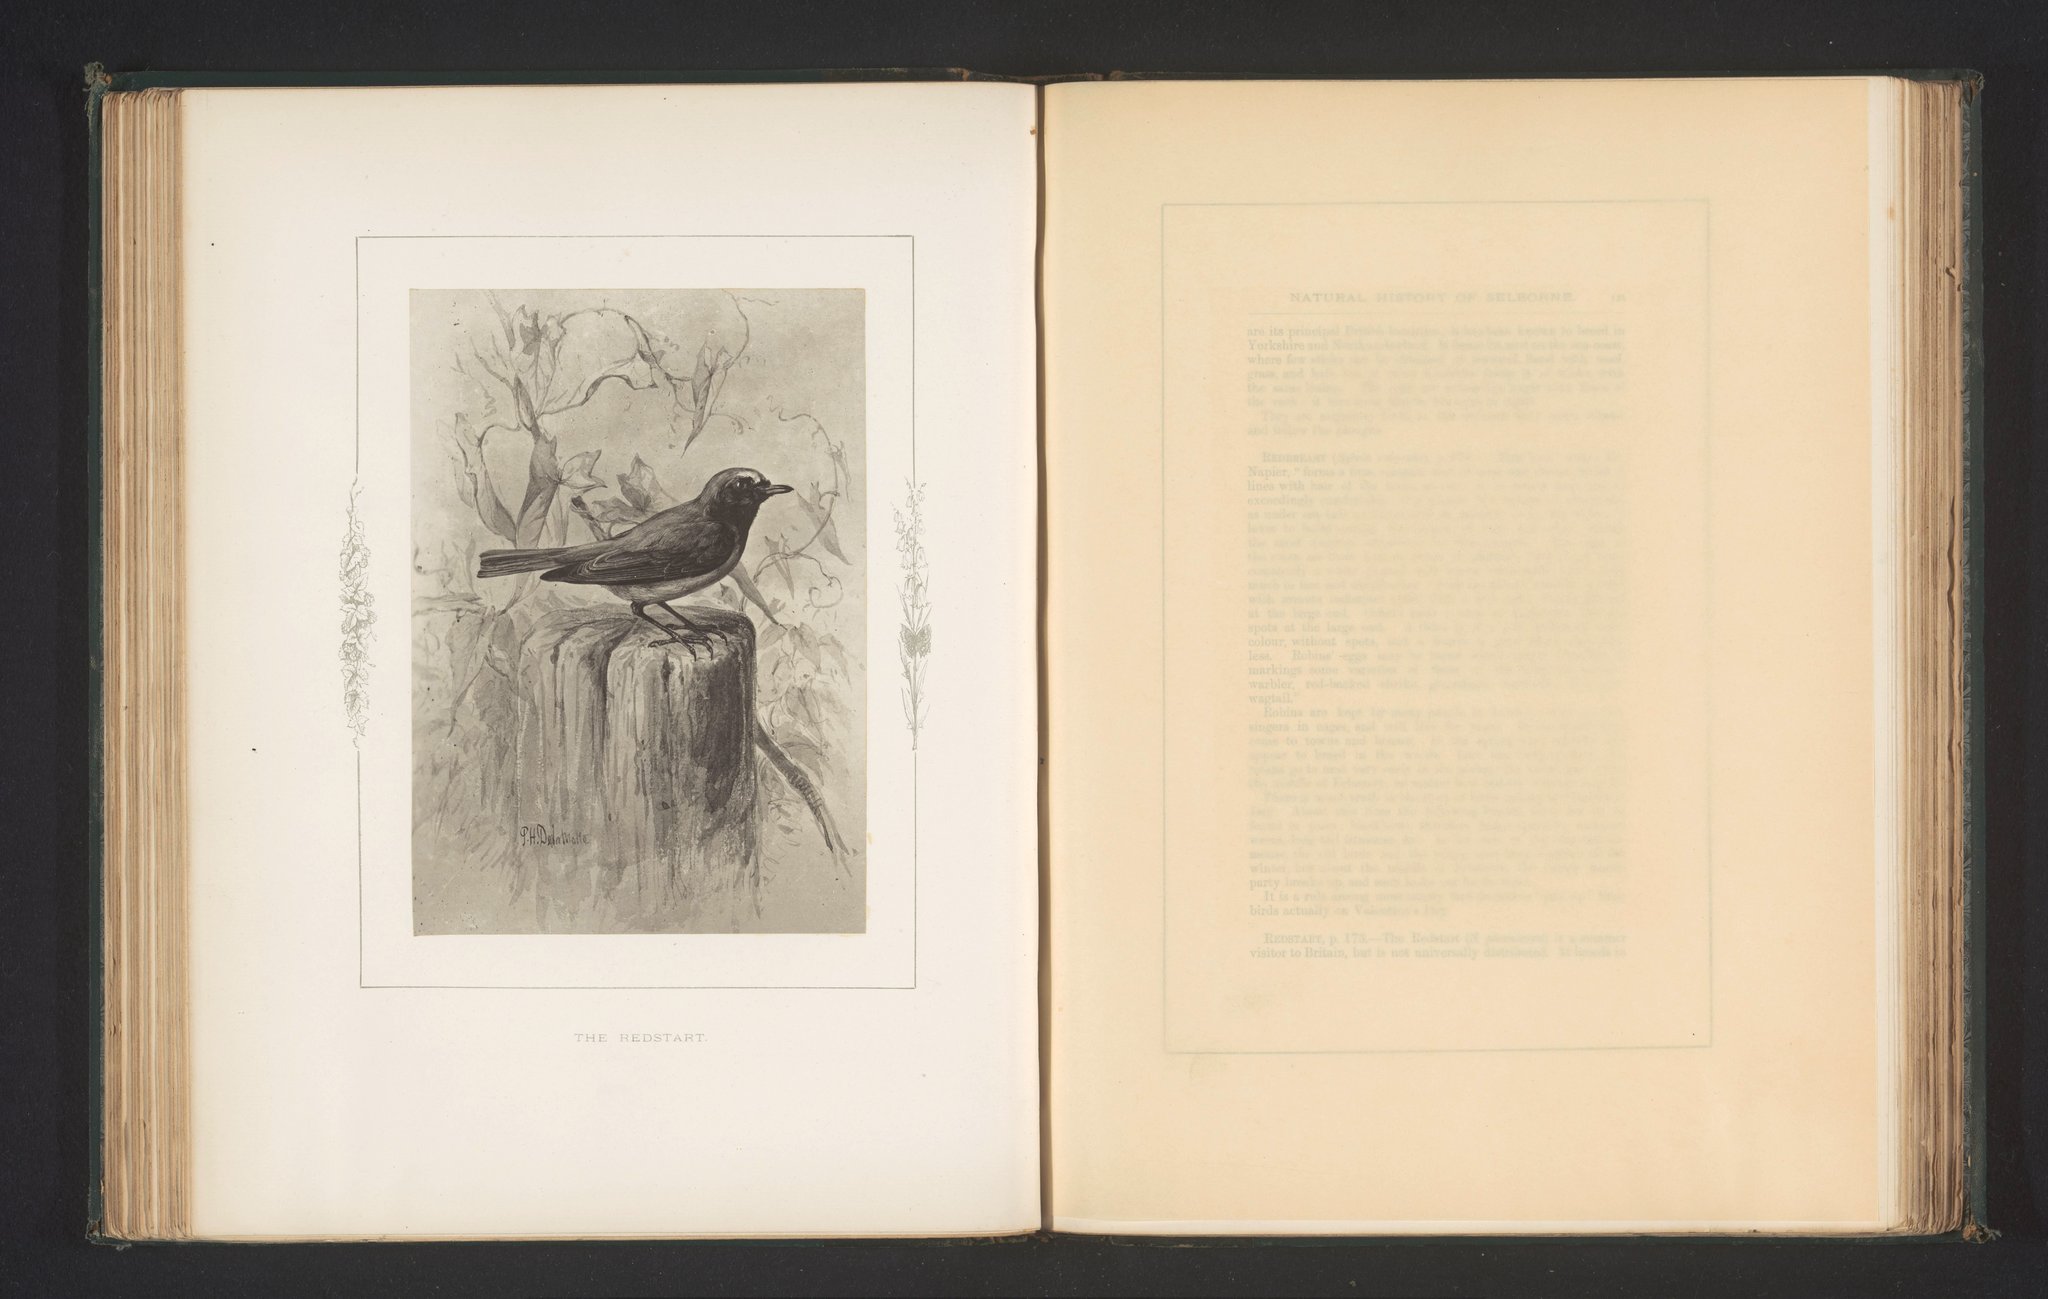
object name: page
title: The redstart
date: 1850-1876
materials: photographic support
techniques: carbon print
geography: selborne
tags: birds